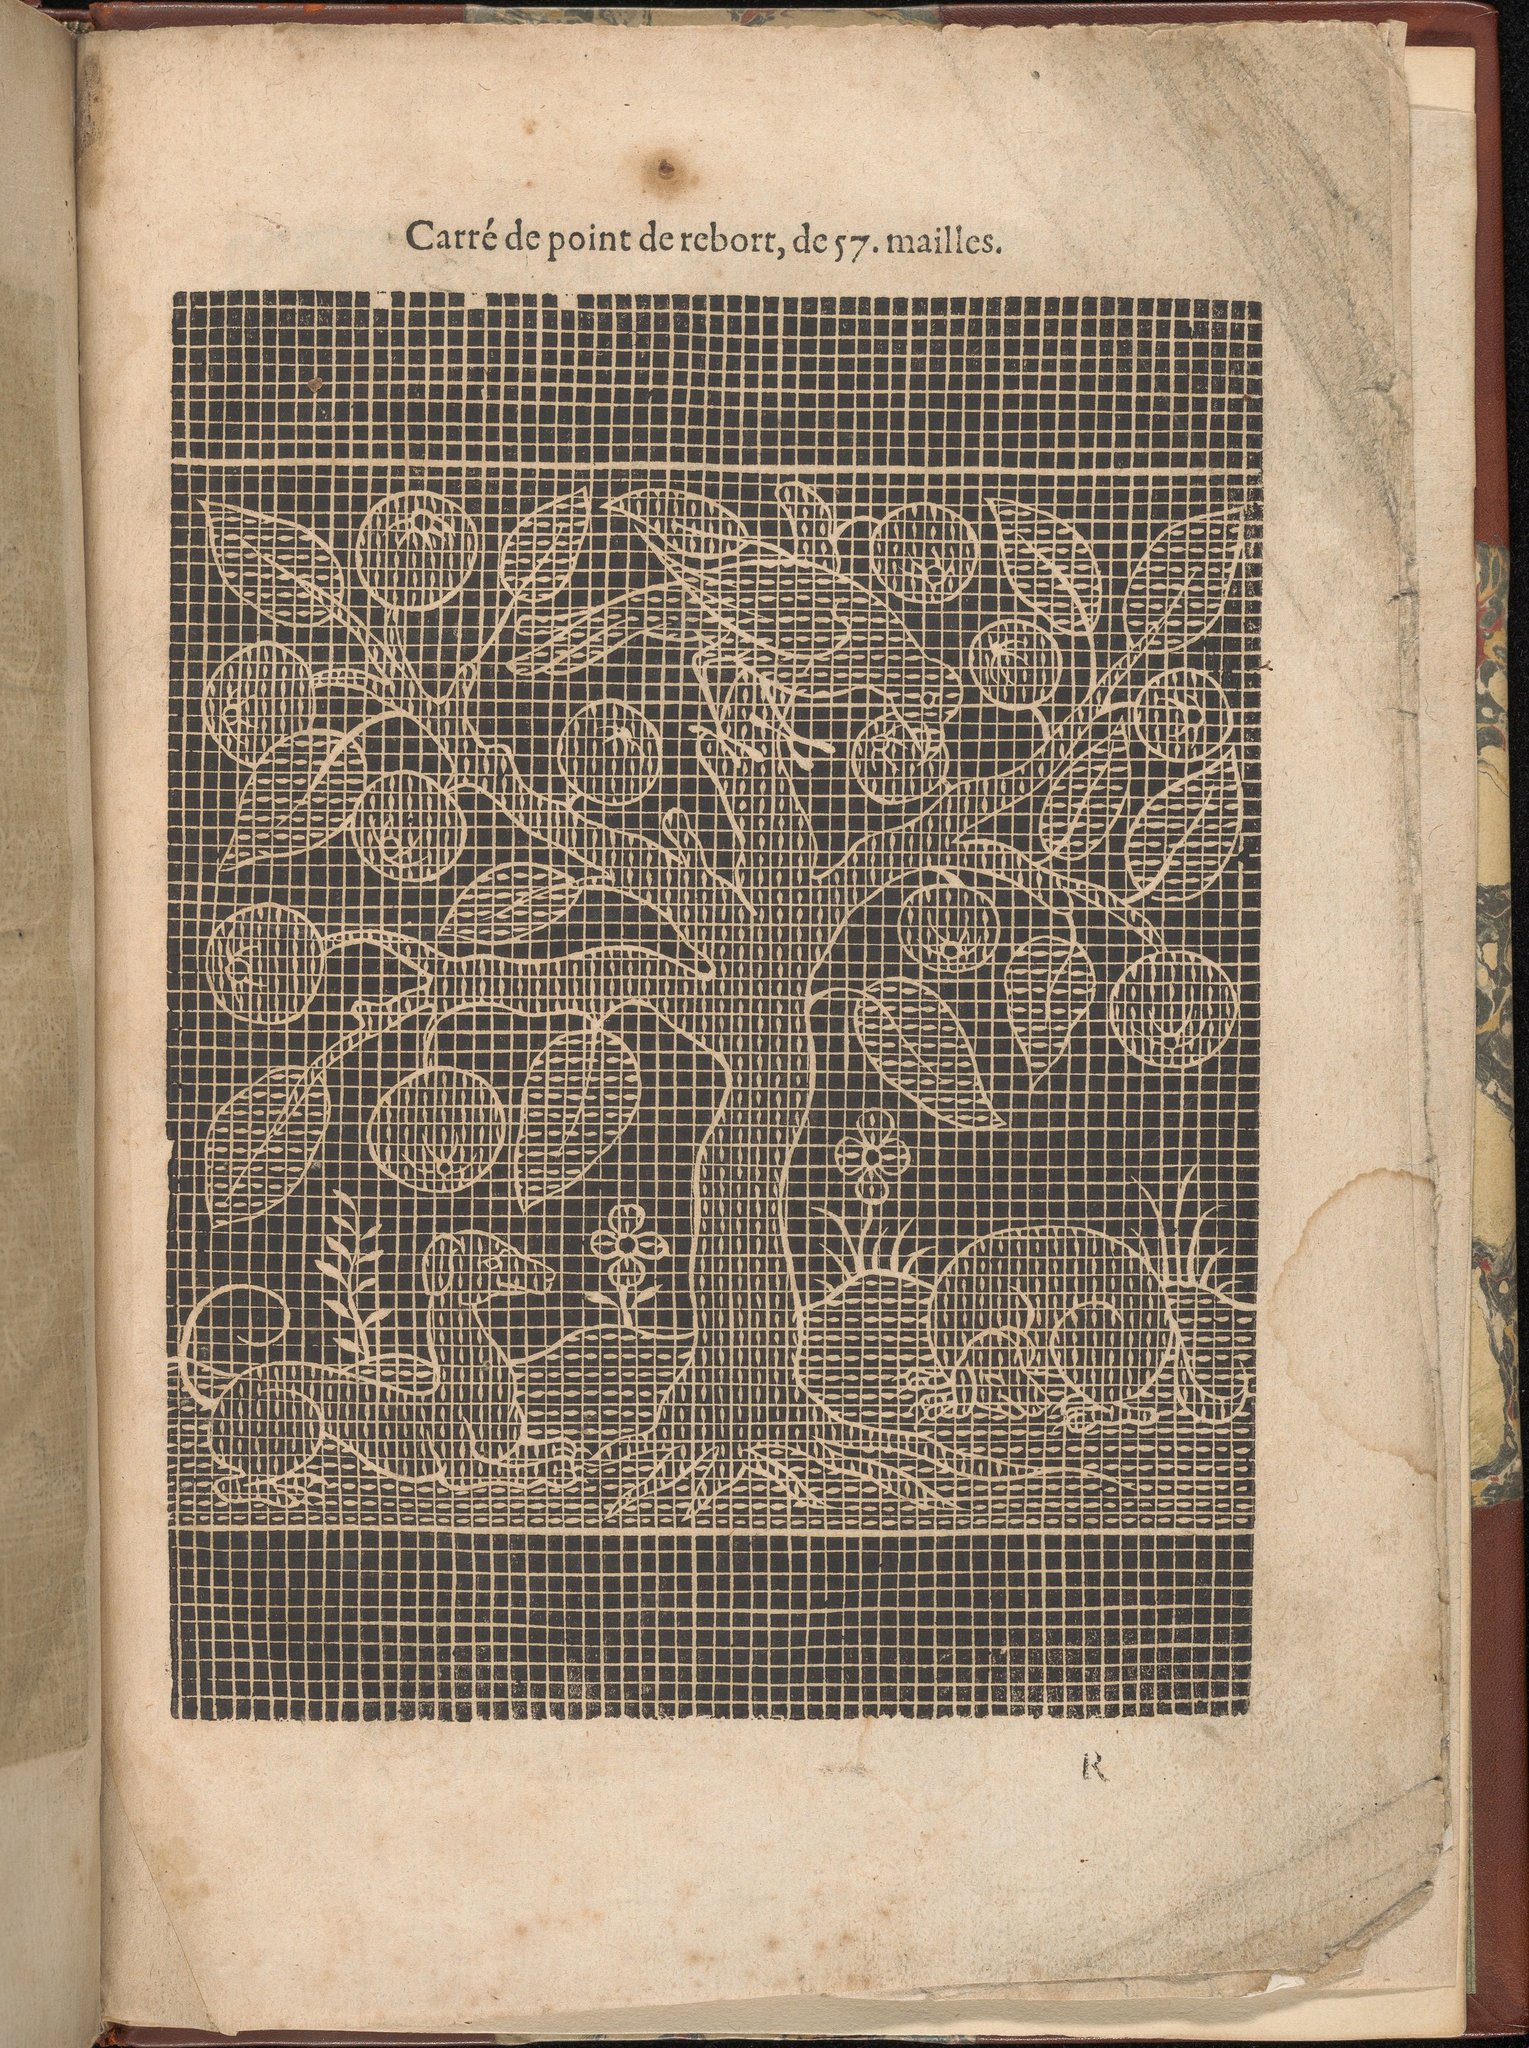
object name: book print ornament architecture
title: Les Secondes Oeuvres, et Subtiles Inventions De Lingerie du Seigneur Federic de Vinciolo Venitien, page 65 (recto)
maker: federico de vinciolo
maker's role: designer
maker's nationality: italian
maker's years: 1582-1599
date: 1603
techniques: woodcut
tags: birds,fruit,dogs,trees